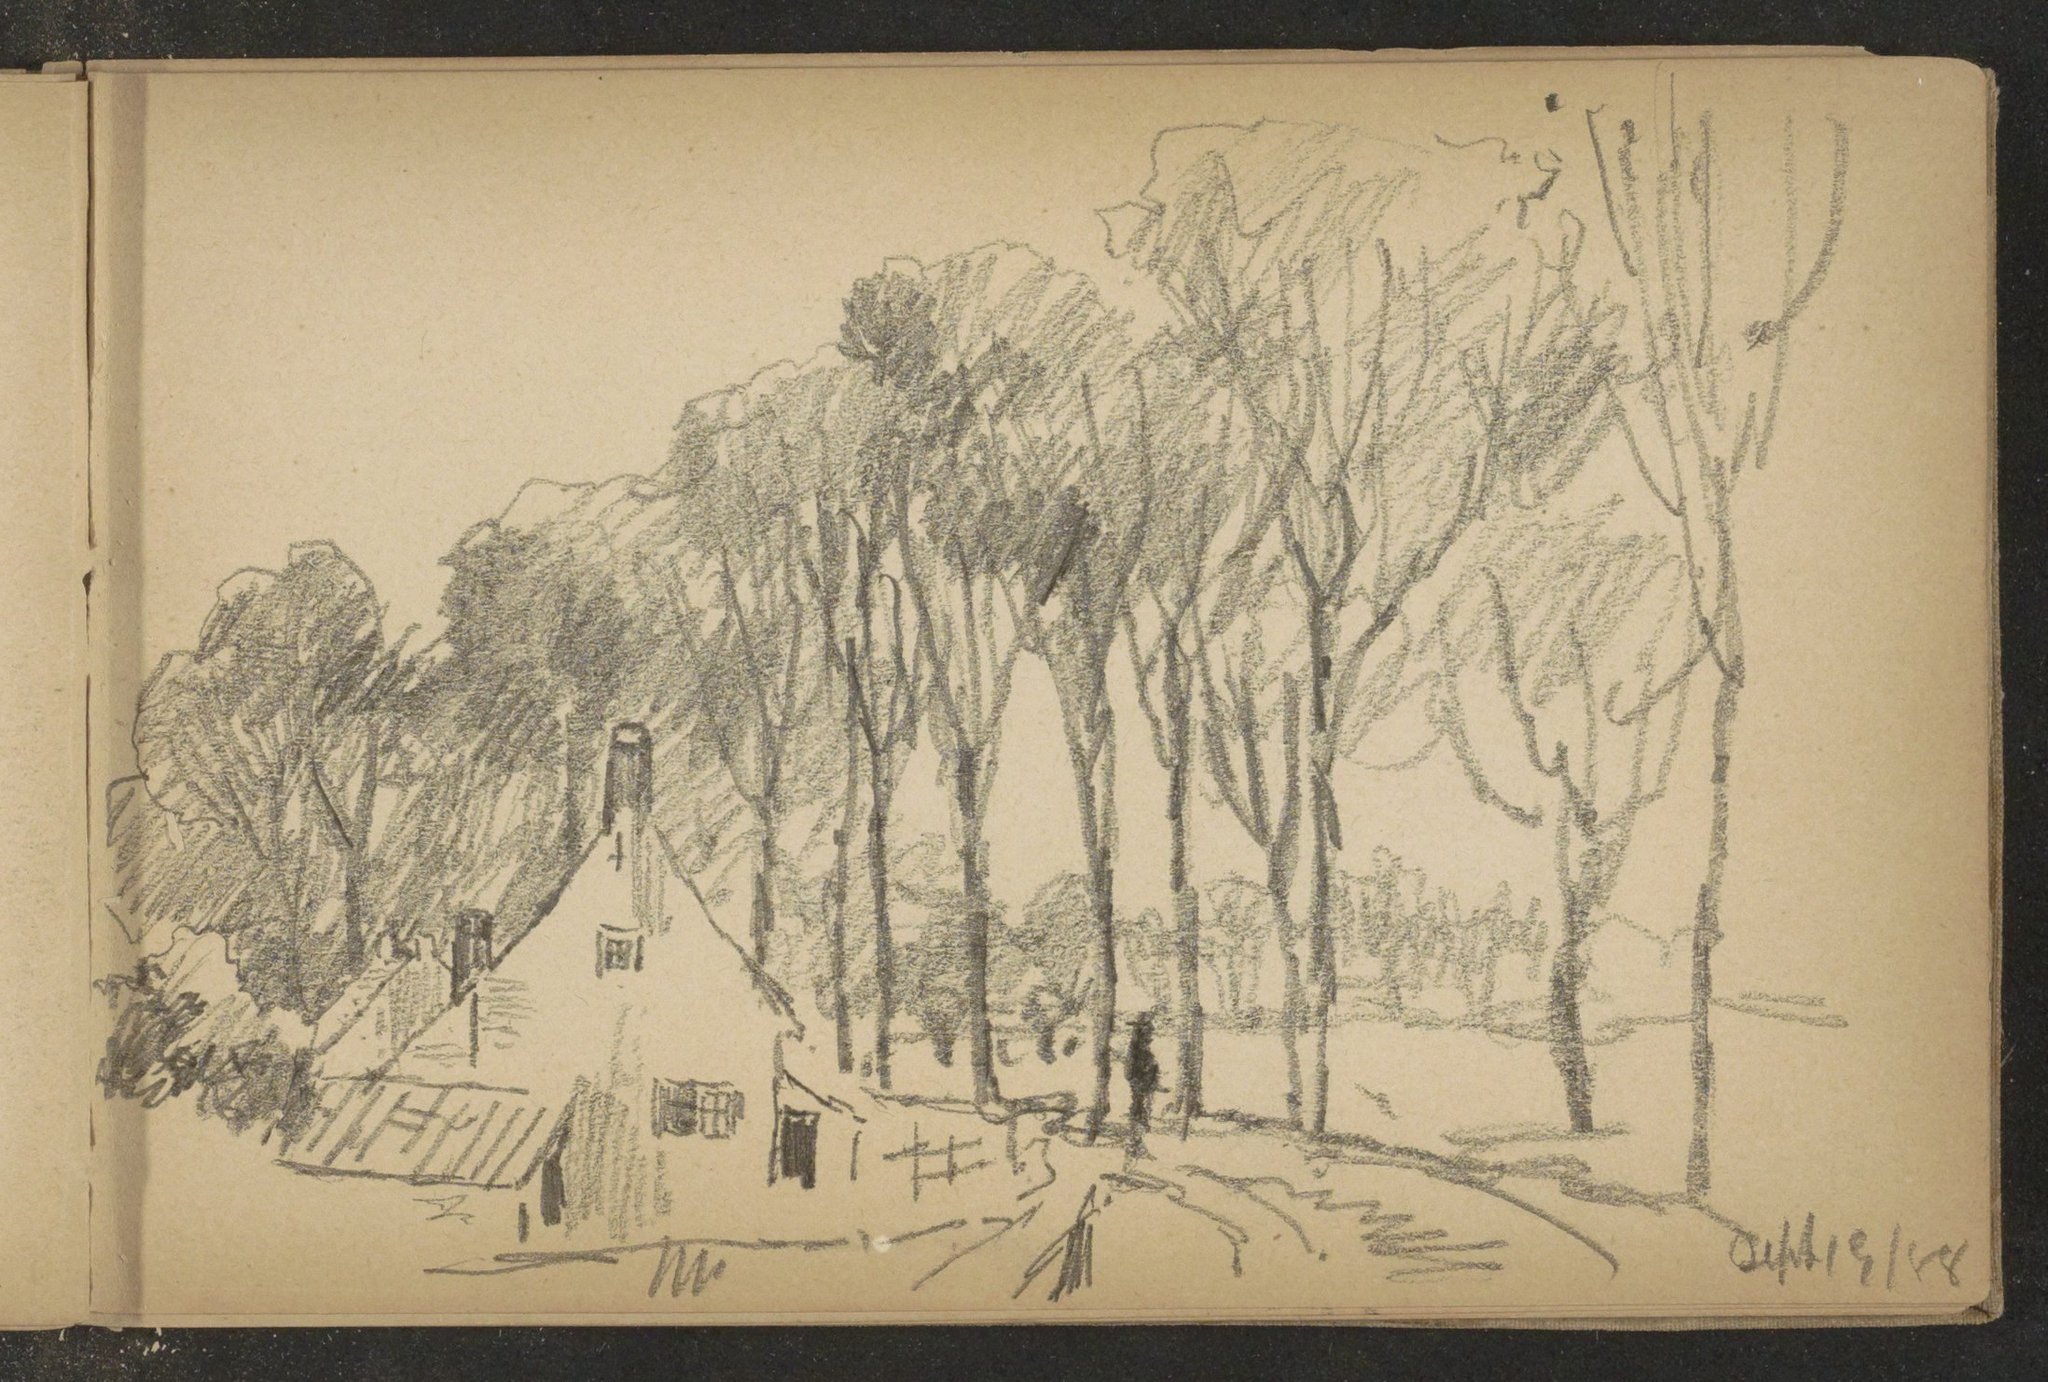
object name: sketchbook leaf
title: Bomenlaan langs een boerderij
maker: alexander shilling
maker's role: draughtsman, print maker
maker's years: 1859-1937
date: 1809-1888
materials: paper, pencil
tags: fence, wall, paling, farm or solitary house in landscape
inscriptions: date: ‘sept 19/88’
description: Blad 28 recto uit een schetsboek met 34 bladen.